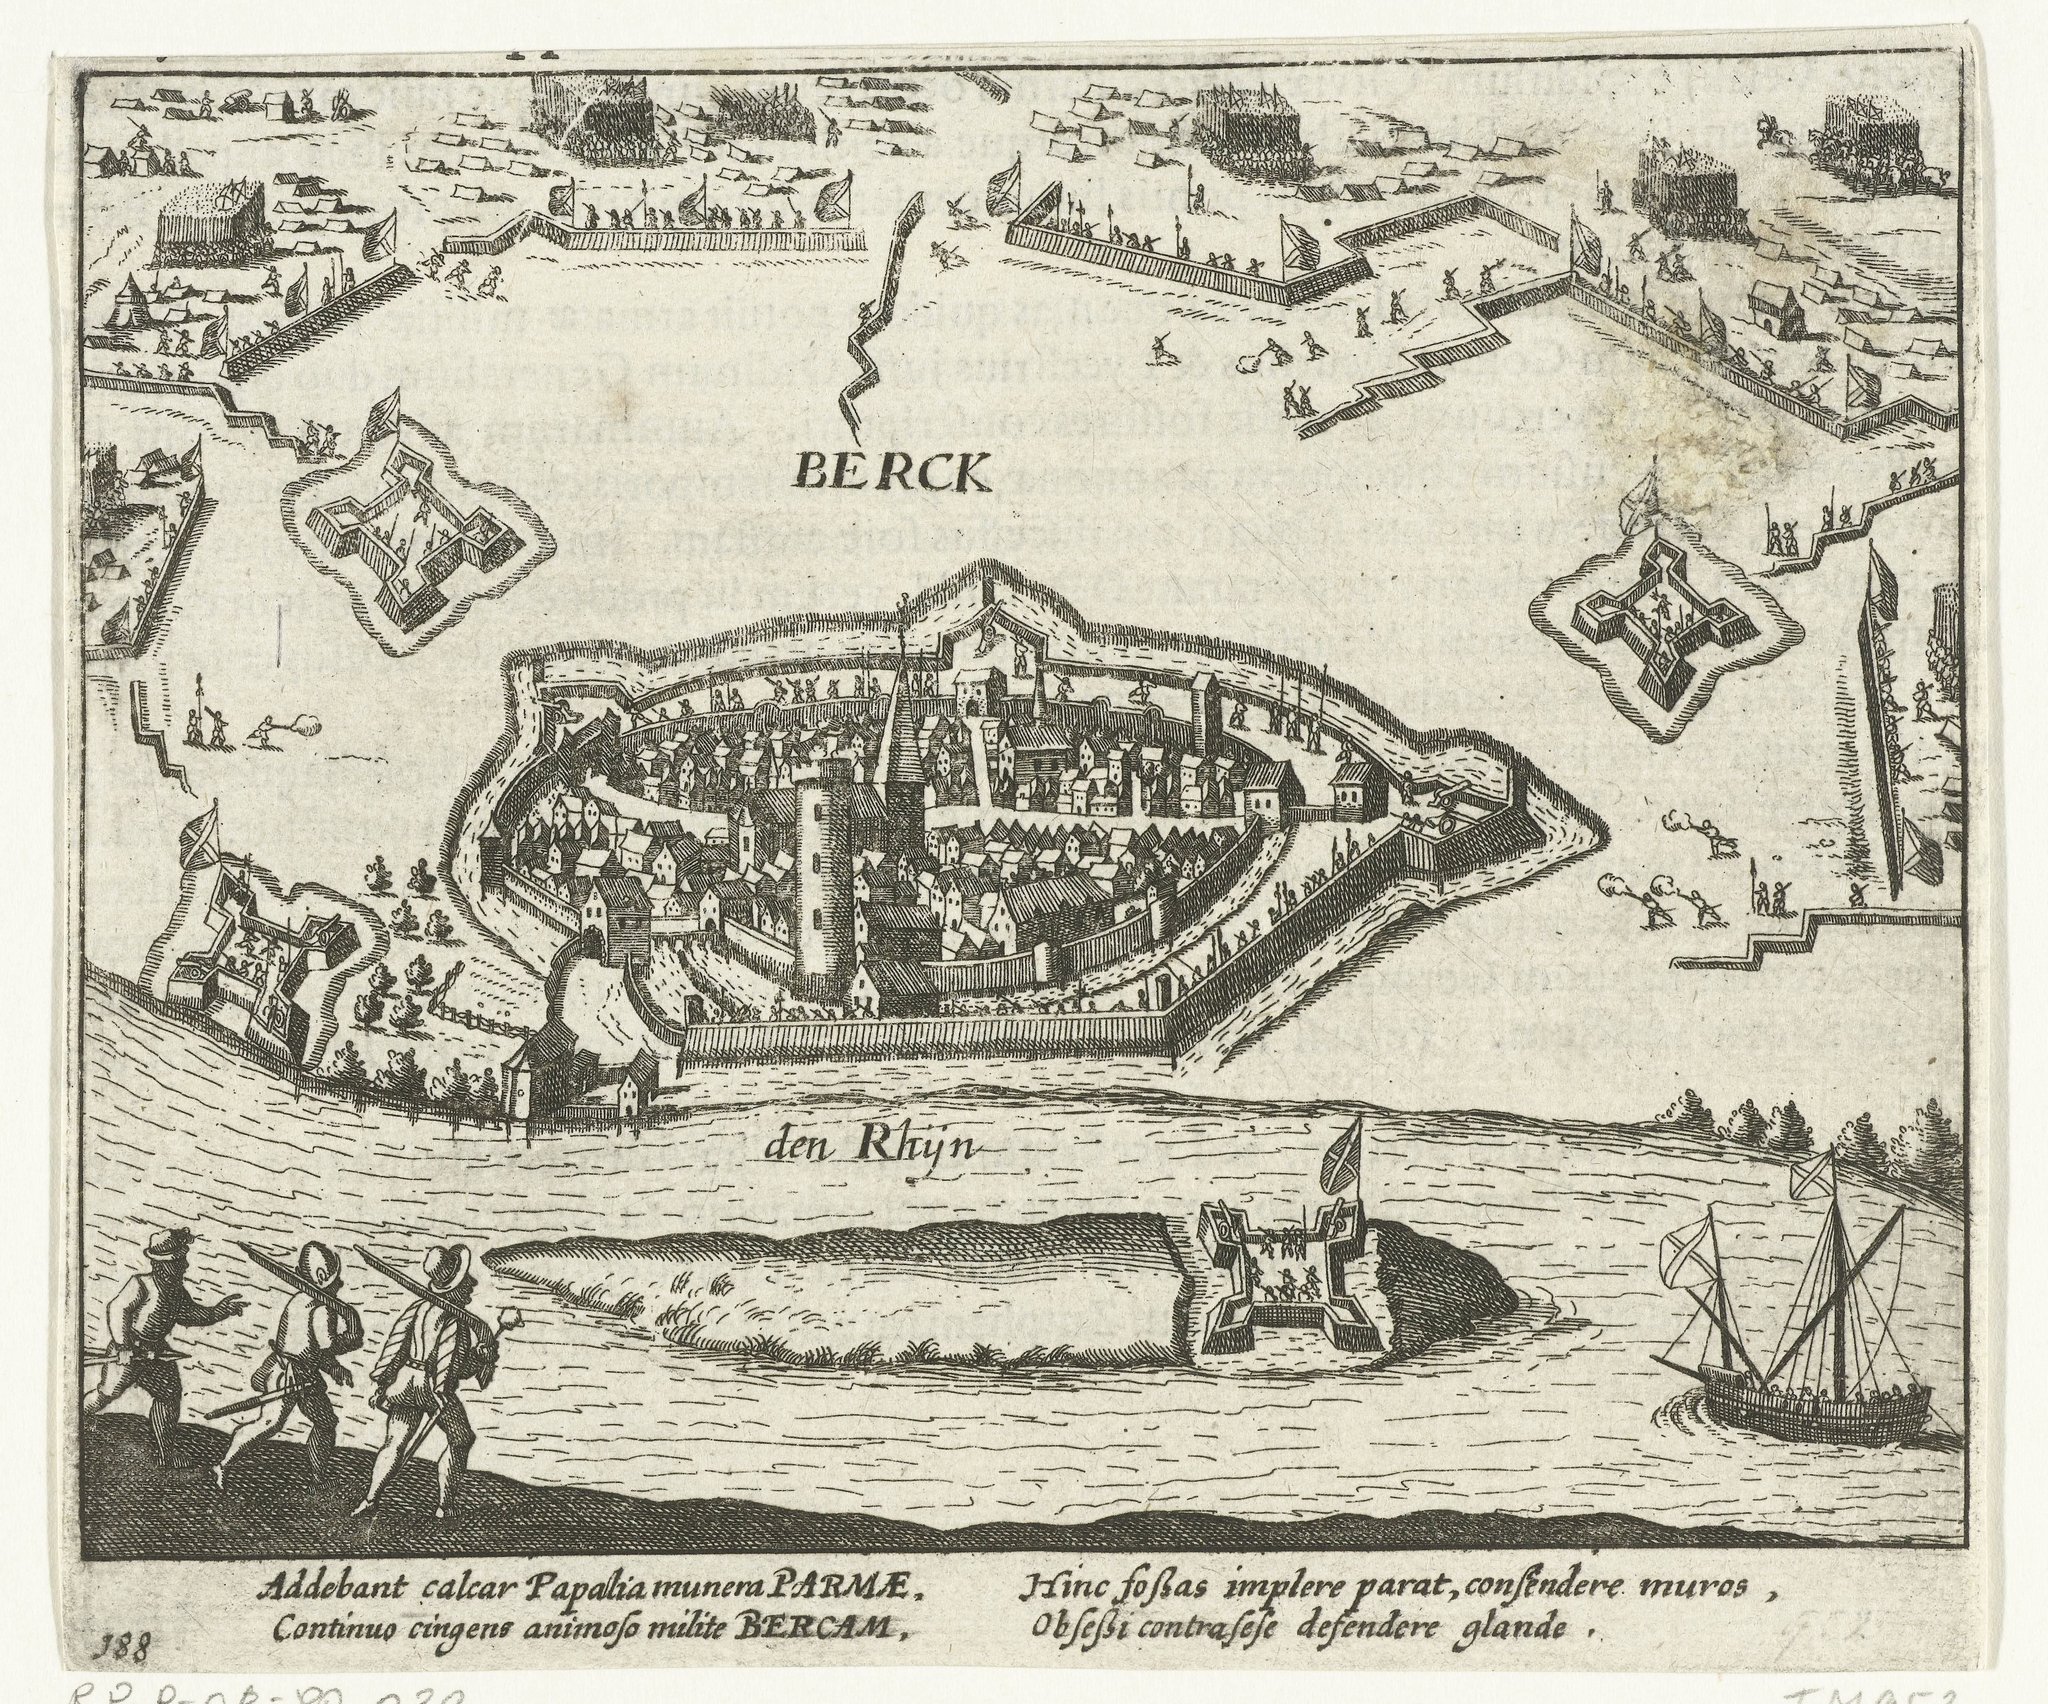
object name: print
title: Beleg van Rheinberg door keurvorst Ernst van Beieren, 1586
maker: Anonymous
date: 1613-1615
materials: paper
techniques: etching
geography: northern netherlands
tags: rijnberg, keulse oorlog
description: Beleg van Rheinberg door keurvorst Ernst van Beieren, september 1586. Episode uit de Keulse Oorlog. Met onderschrift van 4 regels in het Latijn. Genummerd 188. Bedrukt op achterzijde met tekst in het Latijn.